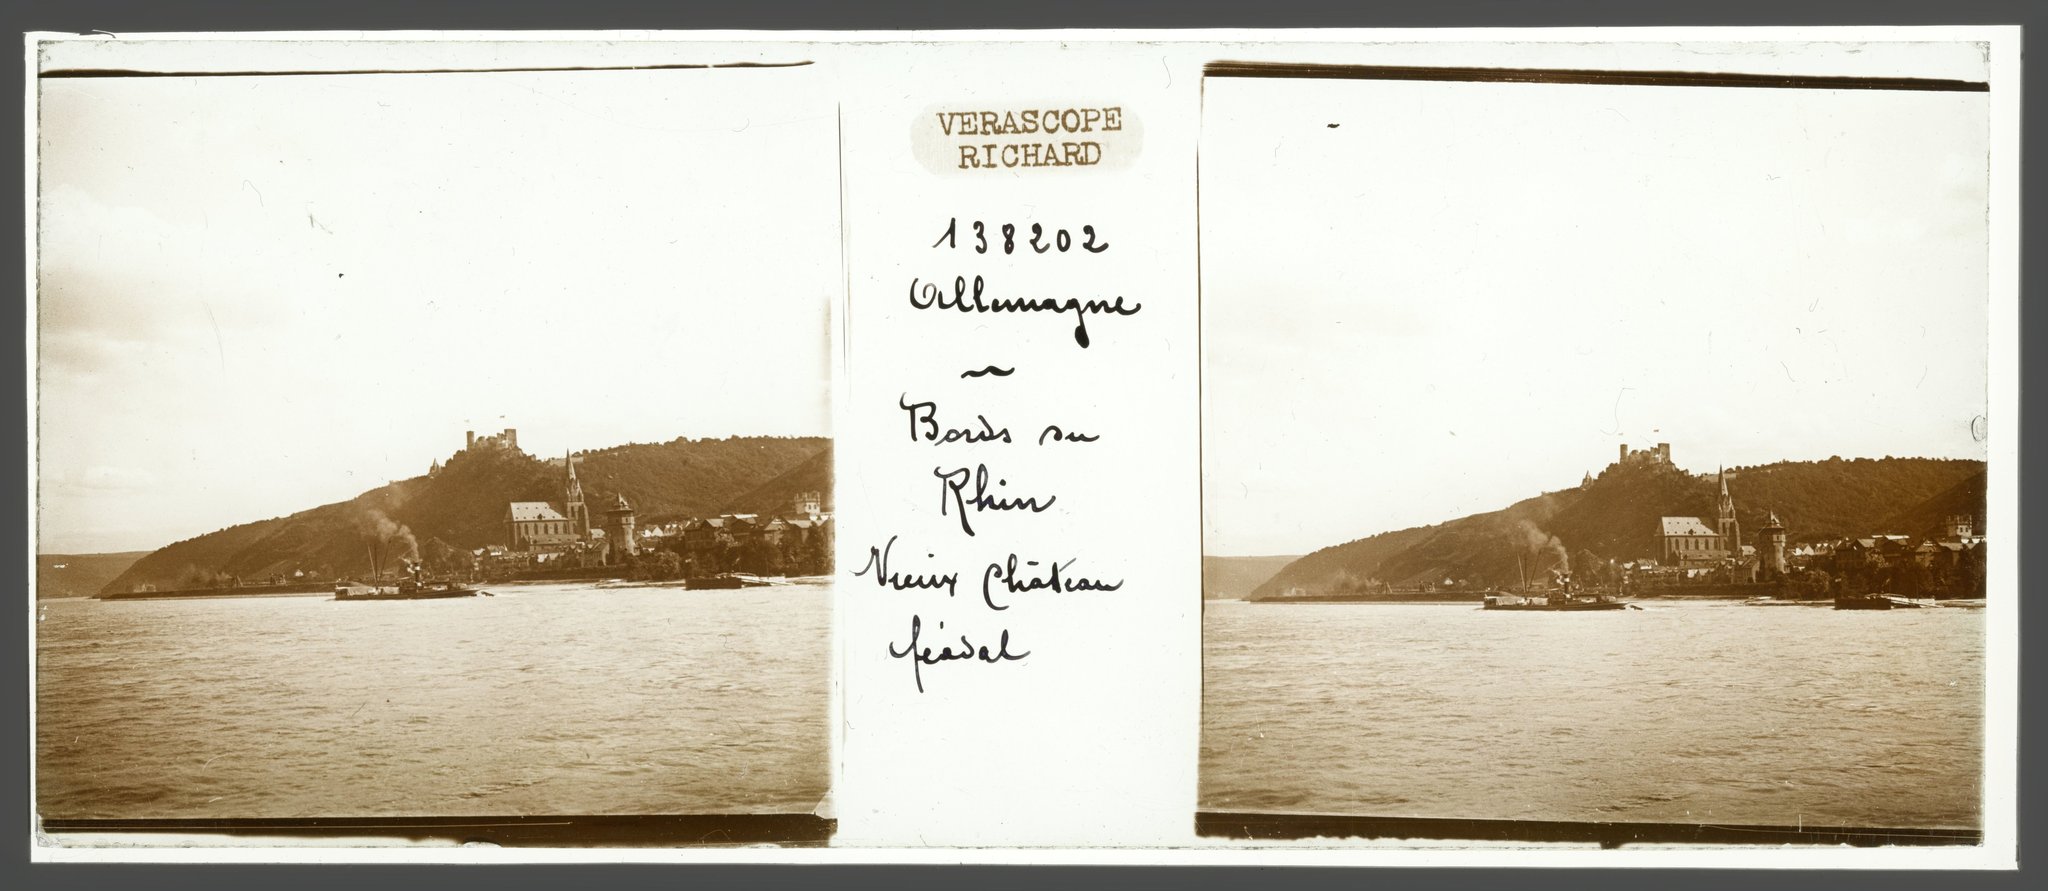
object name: stereoscopic photograph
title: Allemagne - Bords du Rhin, Vieux Château féodal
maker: Anonymous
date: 1893-1920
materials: glass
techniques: gelatin silver transparency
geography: germany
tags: river, landscape with tower or castle, steamship, motorship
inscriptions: number: ‘138202’